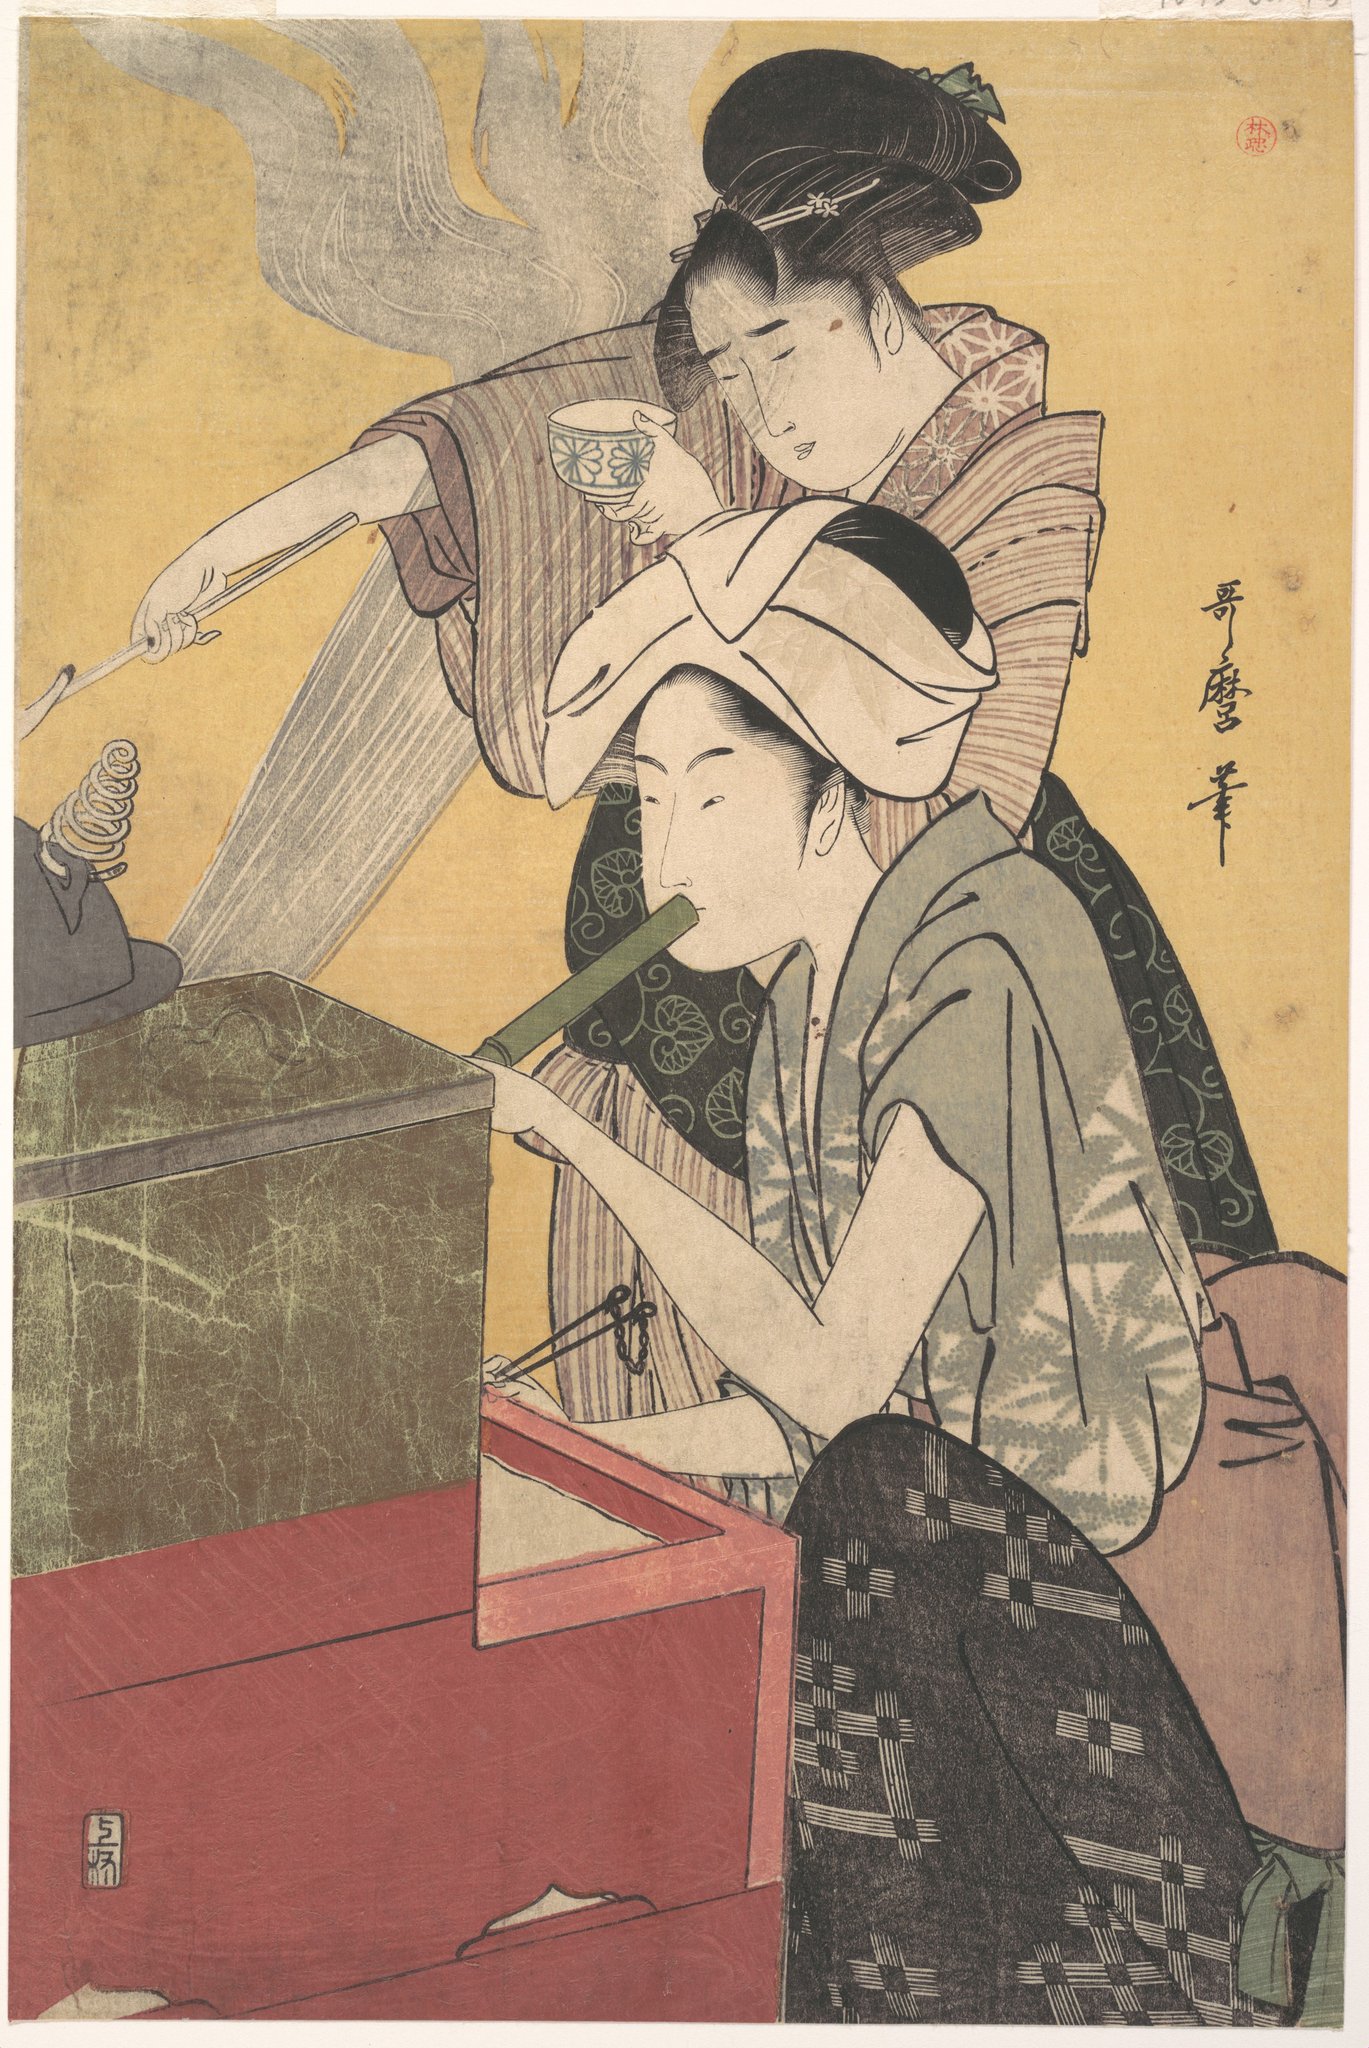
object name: print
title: In the Kitchen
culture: japanese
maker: kitagawa utamaro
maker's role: artist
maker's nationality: japanese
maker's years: 1754-1806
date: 1794-1795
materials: ink, paper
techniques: woodblock print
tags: kitchens,women,working,cooking